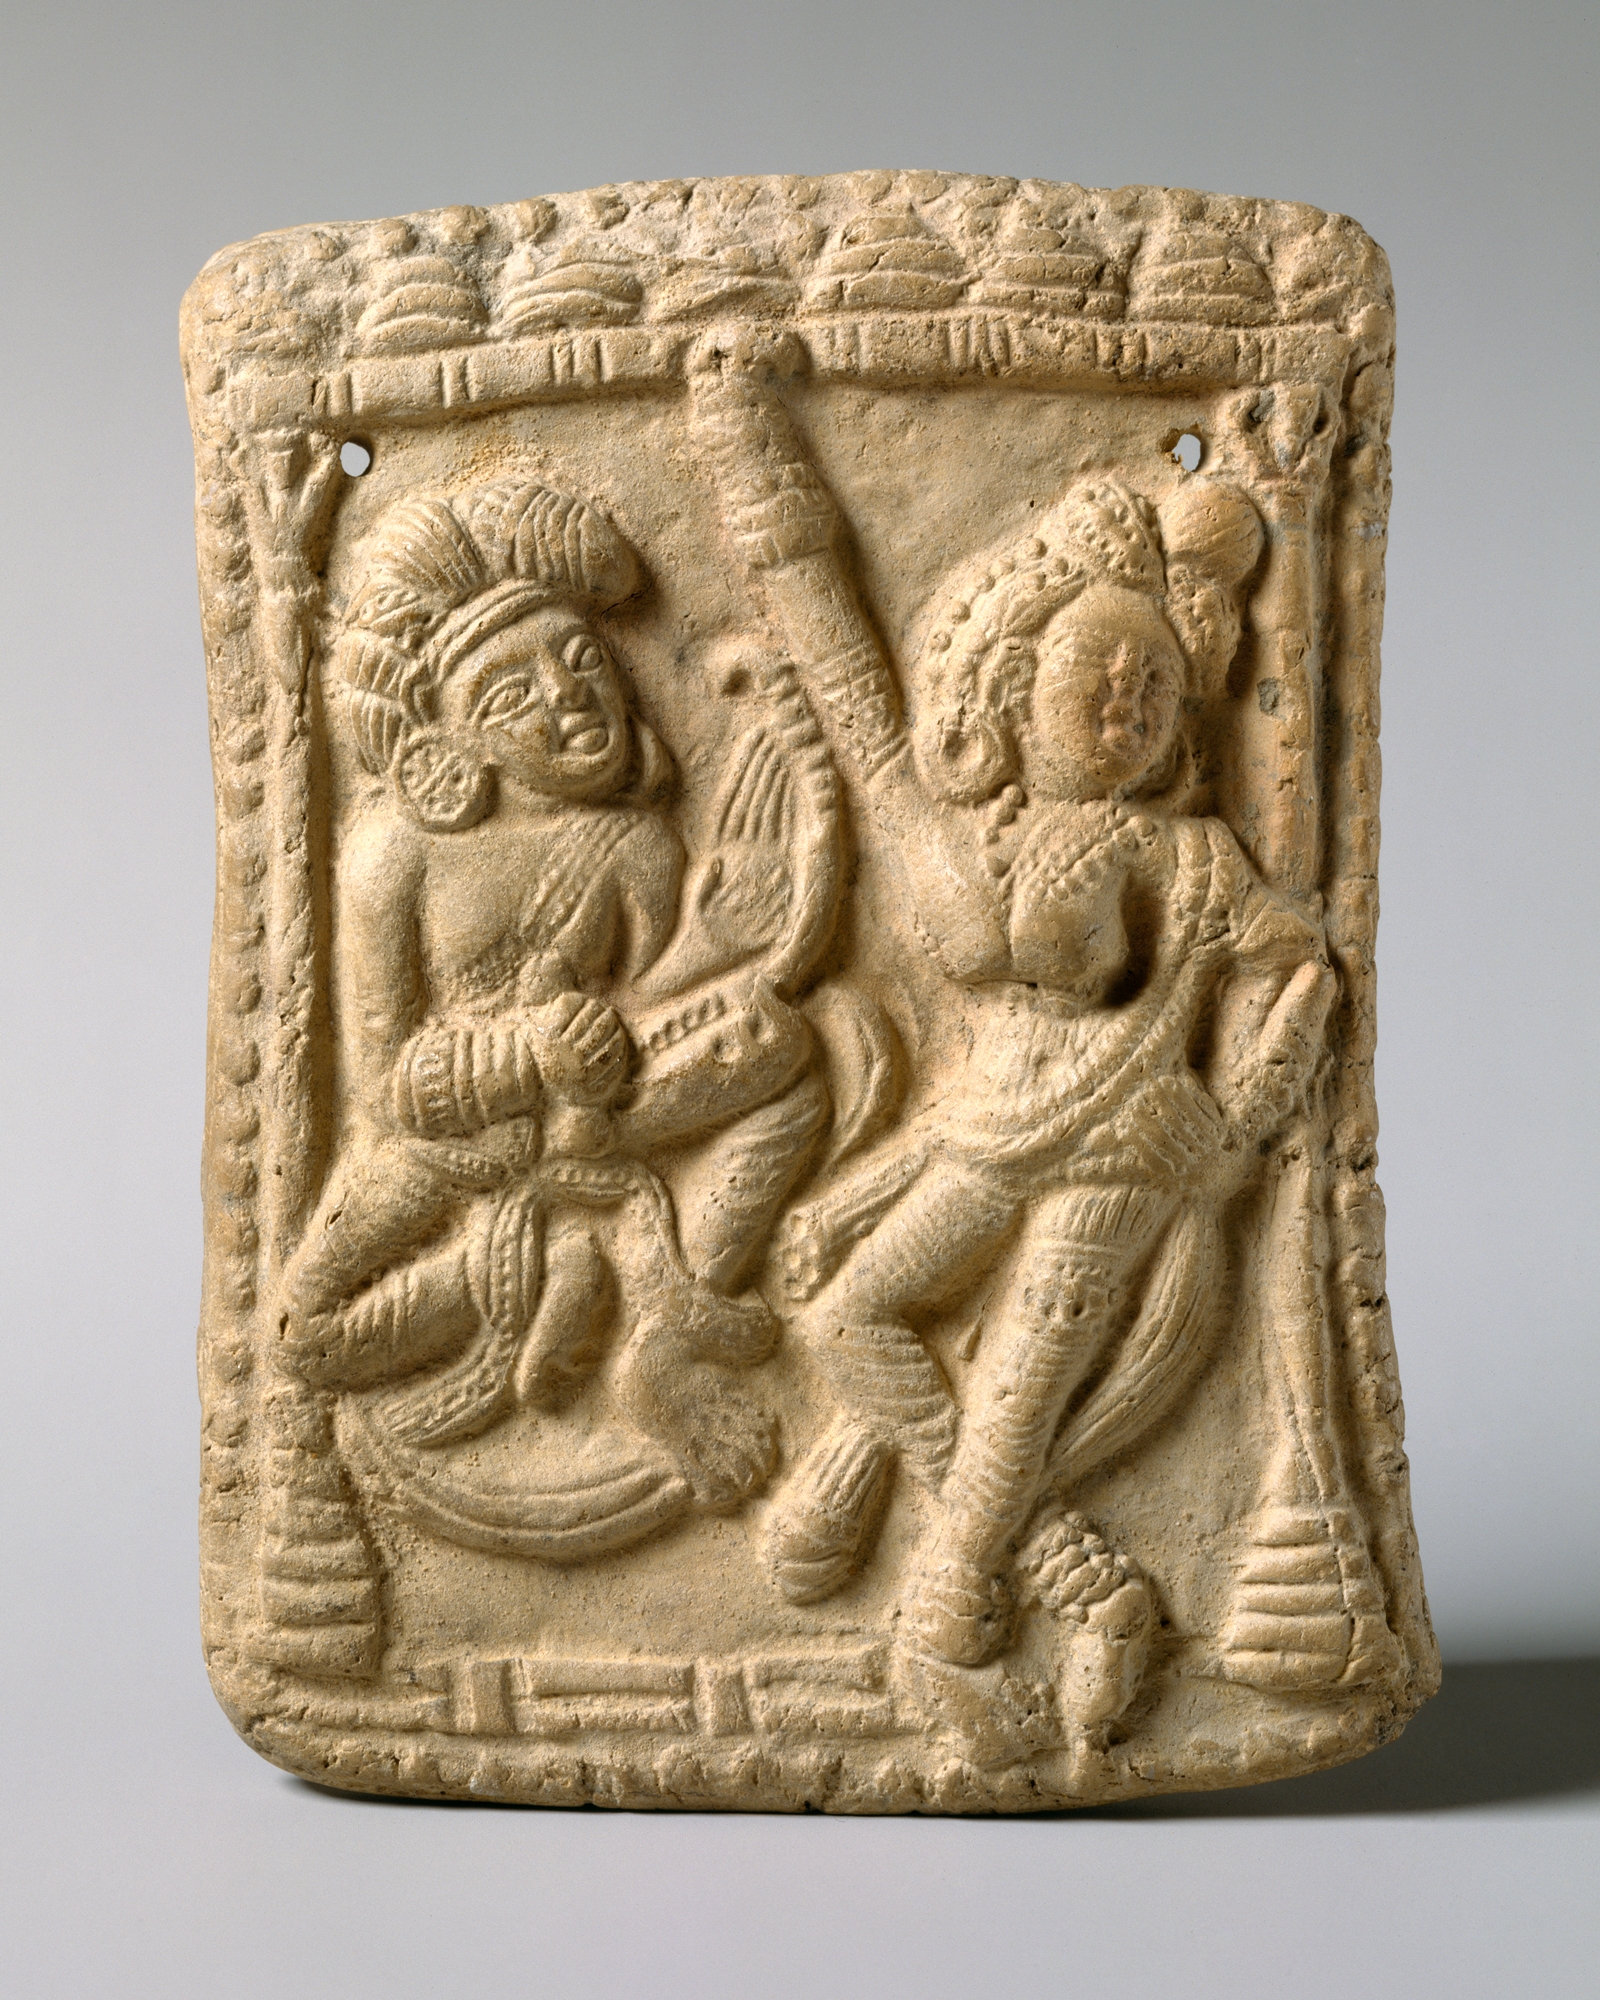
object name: plaque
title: Plaque with a Dancer and a Vina Player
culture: indian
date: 100-1 BCE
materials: terracotta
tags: musical instruments,dancers,musicians